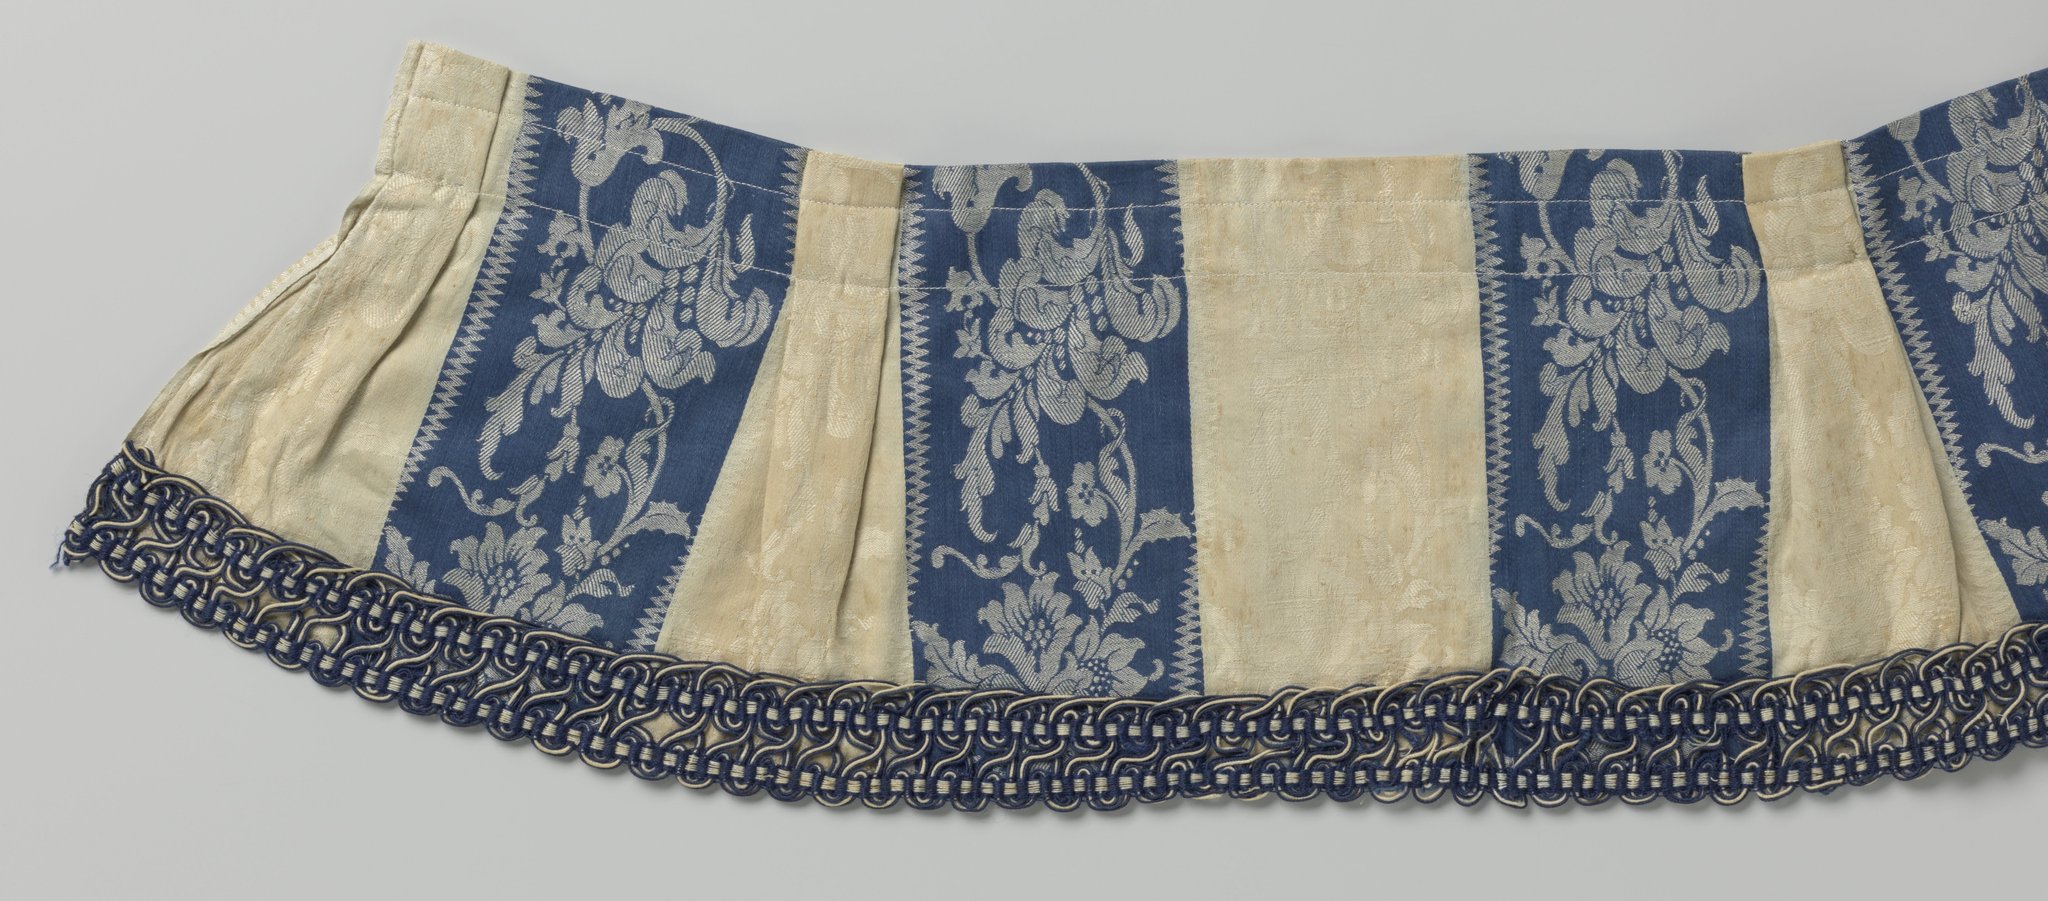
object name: strip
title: Strook van blauw en wit gestreept linnendamast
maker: Anonymous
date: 1880-1900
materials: linen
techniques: damask, weave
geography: france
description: Strook van blauw en wit gestreept linnendamast. De blauwe en w itte strepen hebben beide een lopend patroon van bloemenranken; de blauwe in lichtblauw, de witte in wit.